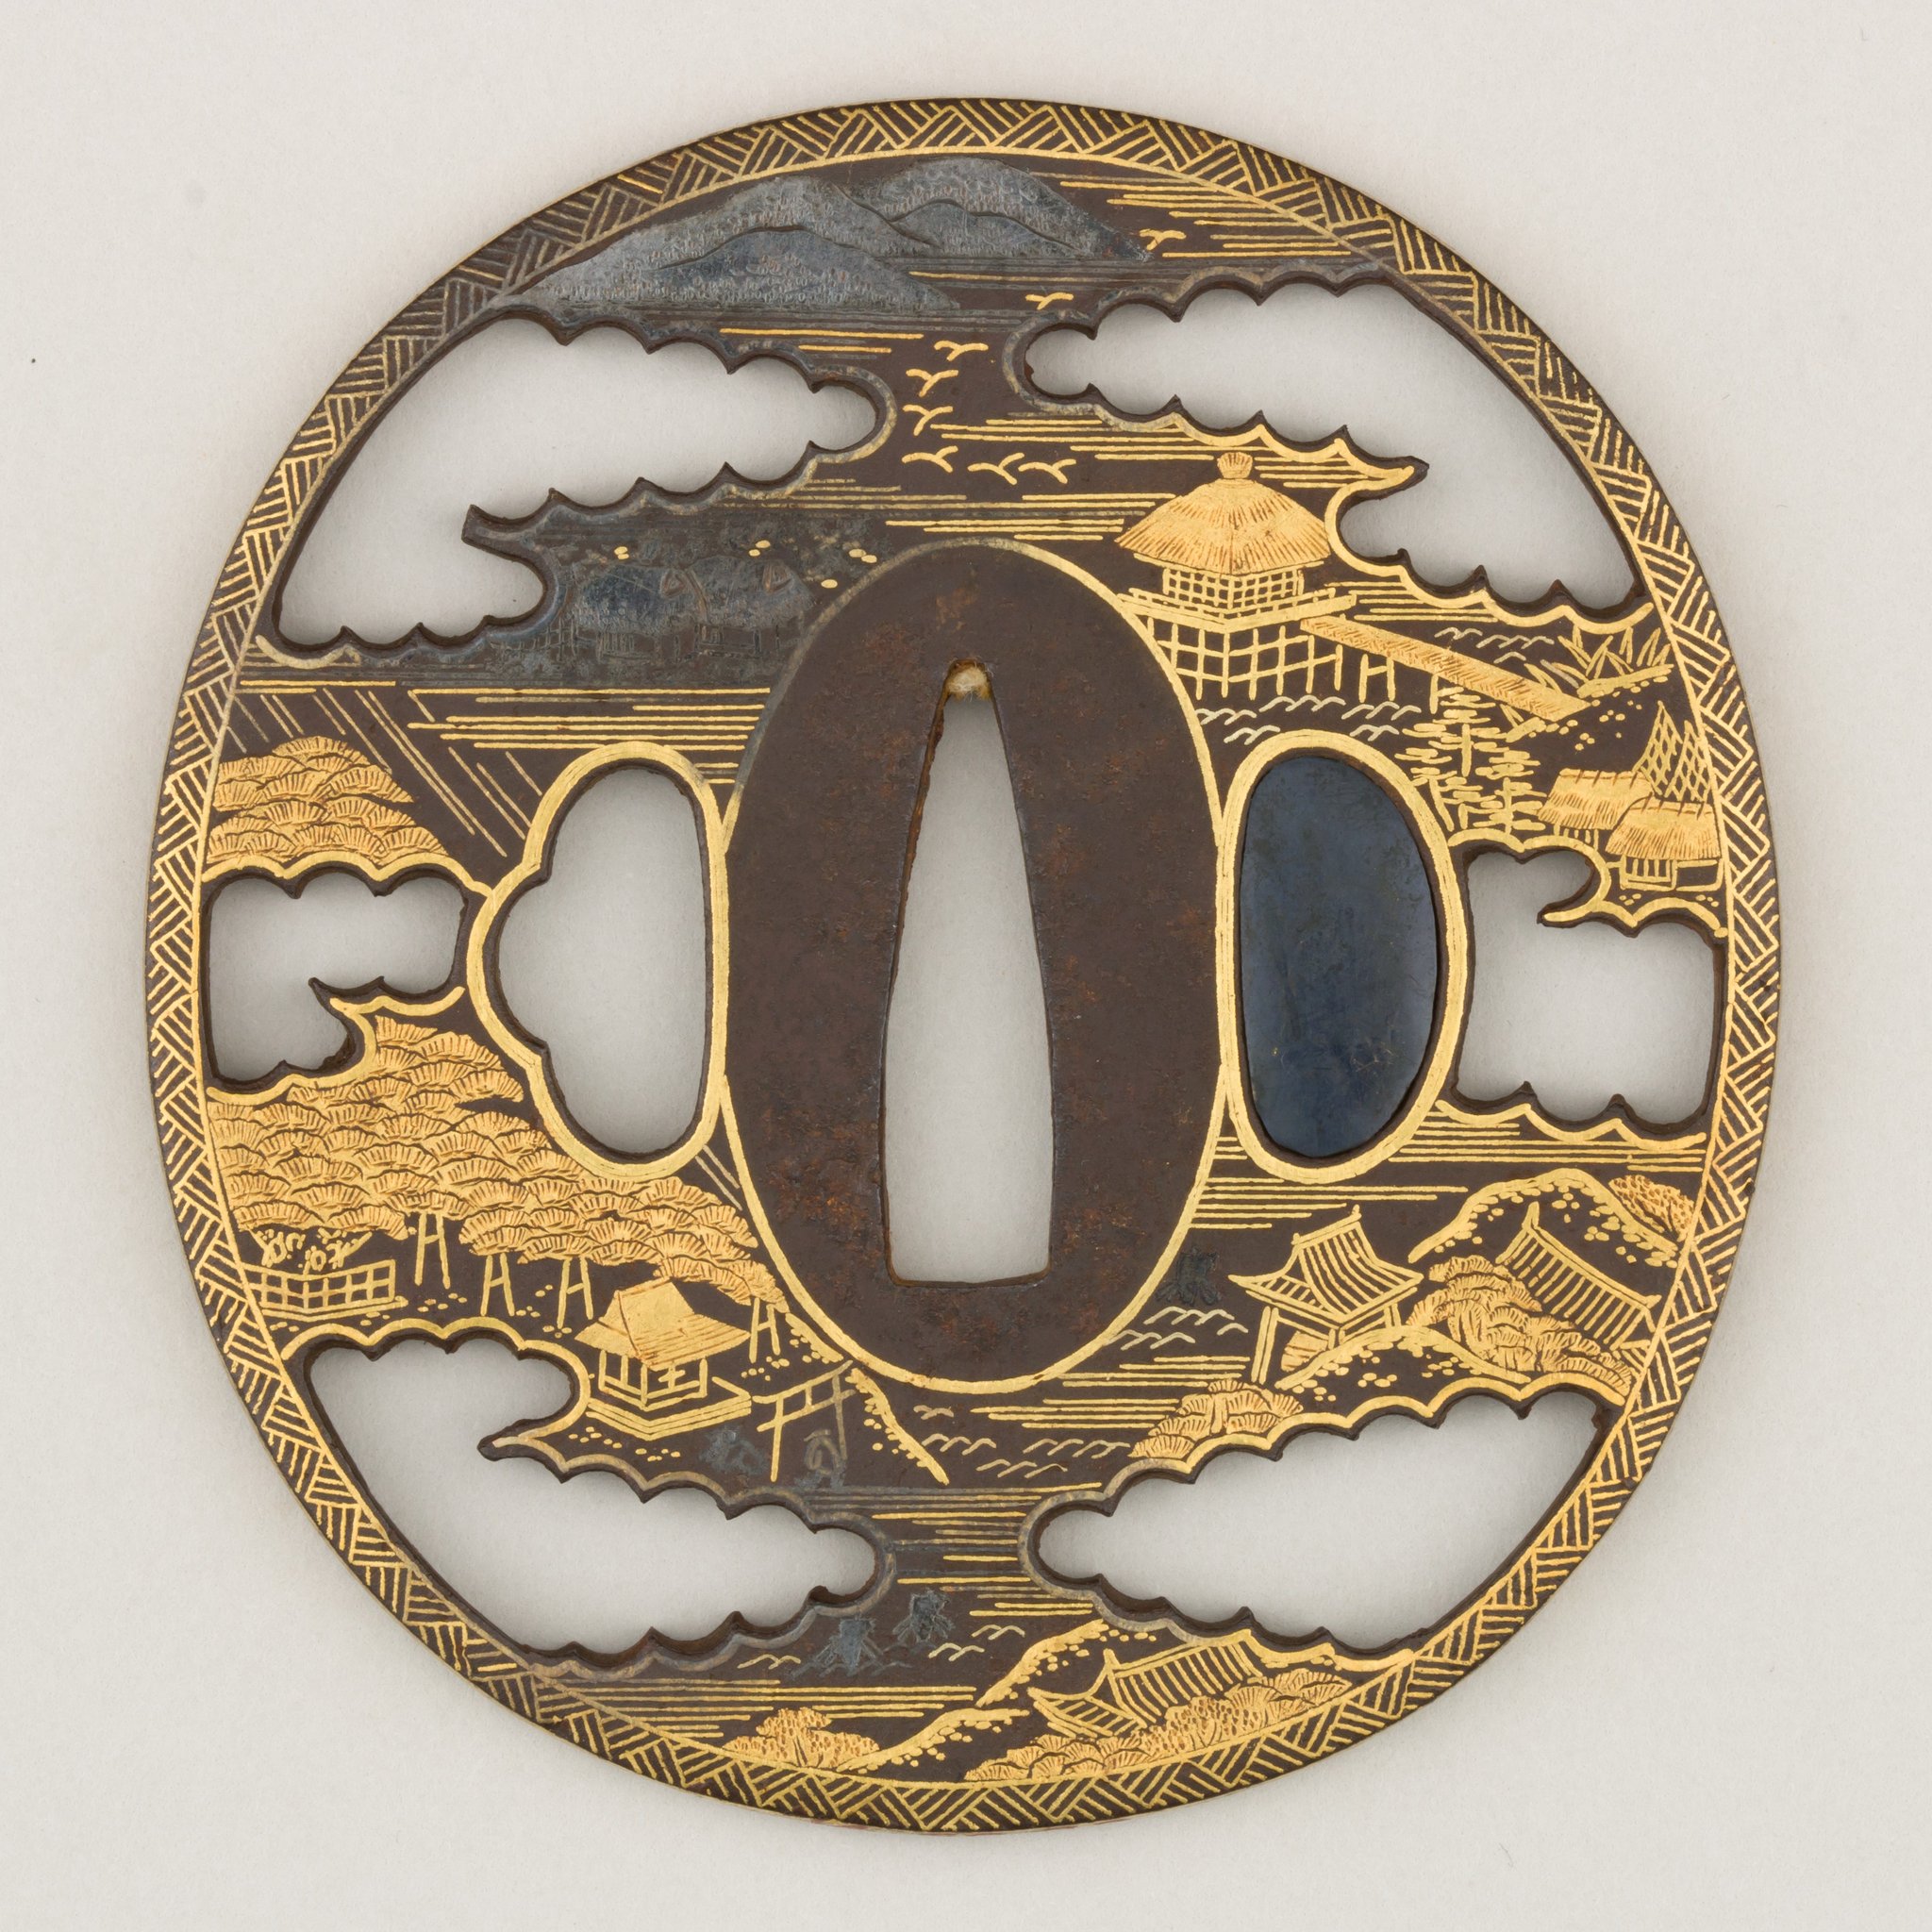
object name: sword guard tsuba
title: Sword Guard (Tsuba)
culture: japanese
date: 1701-1800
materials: copper, gold, iron, silver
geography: japan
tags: buildings